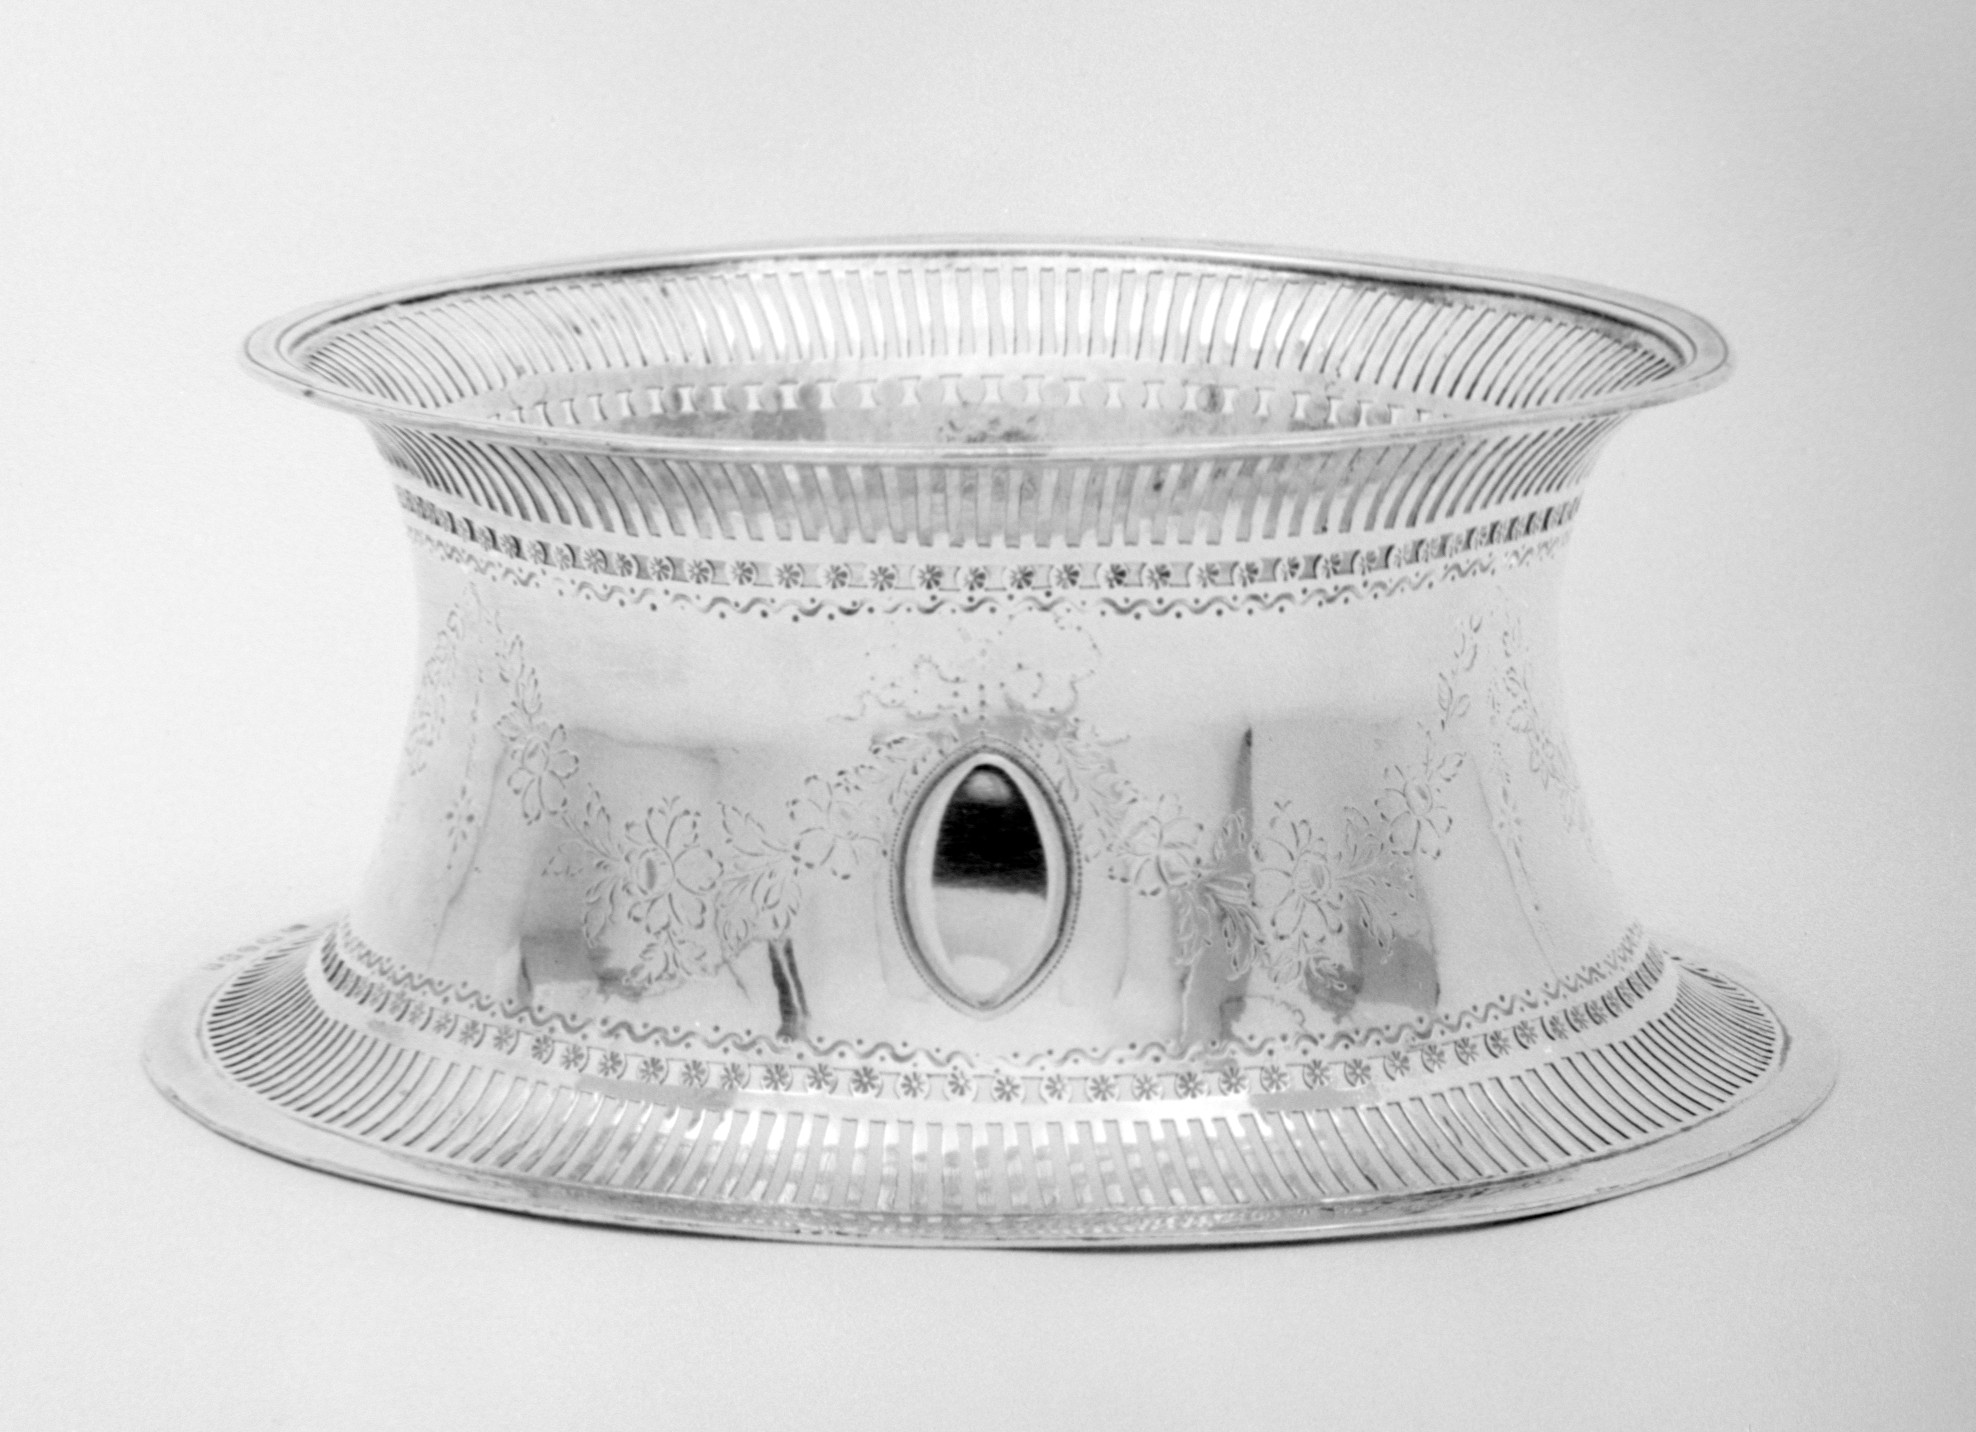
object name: dish ring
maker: henry freeth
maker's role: maker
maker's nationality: british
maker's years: 1789-1852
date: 1816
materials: metal